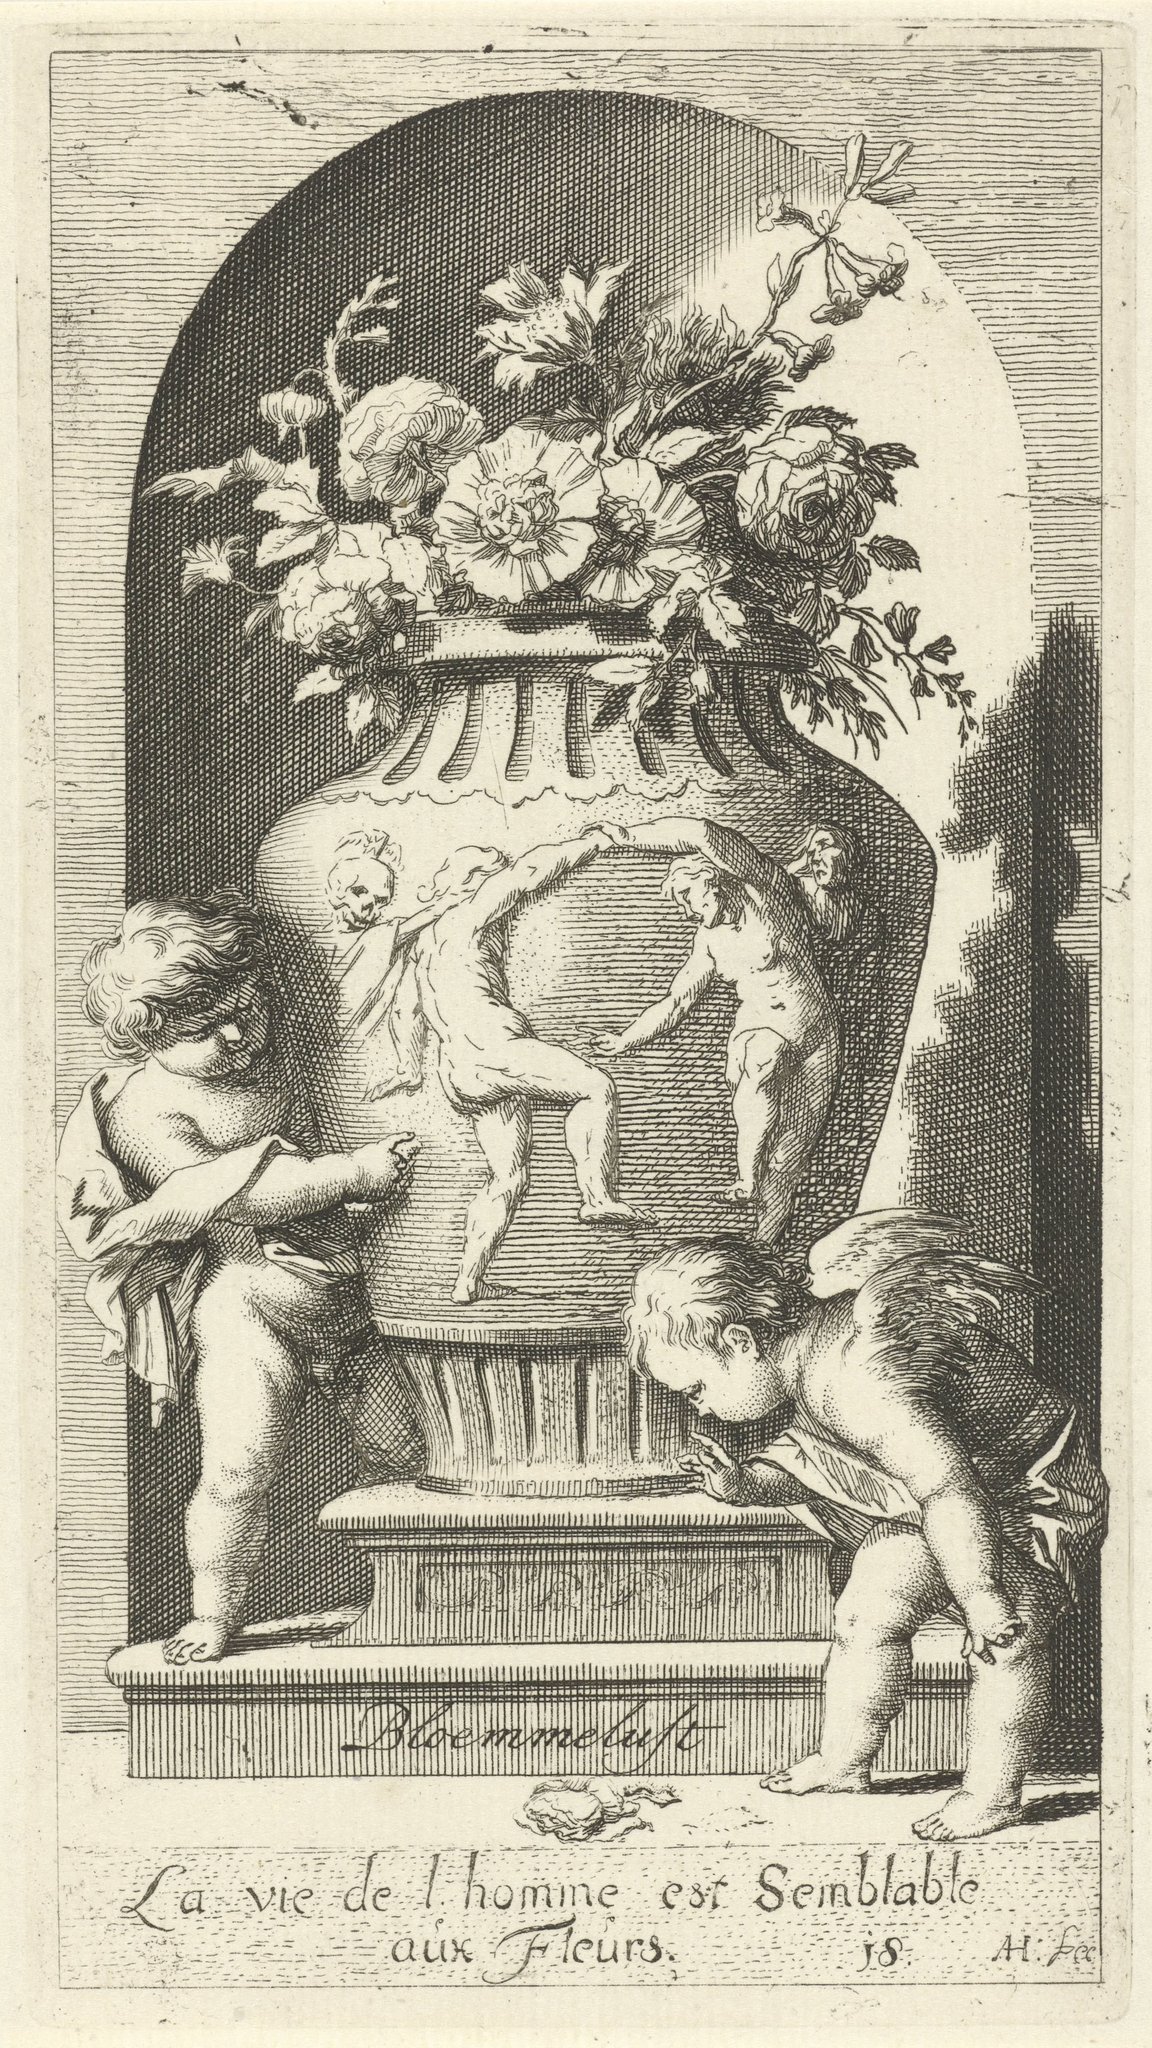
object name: print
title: Twee putti bij een vaas met bloemen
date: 1710-1719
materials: paper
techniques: engraving, etching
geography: amsterdam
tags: angel(s) represented as child(ren), garden vase, vitality and mortality (opposing concepts), flowers (+ plants used symbolically)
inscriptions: collector's mark: Lugt 2228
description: Twee putti bij een tuinvaas met bloemen in een nis. De rechter putto kijkt naar een verwelkte roos op de grond. De linker putto wijst naar de vaas, waarop de Dood de schouder vastheeft van een dansend figuur. Onderaan twee regels in het Frans, met een vergelijking van het menselijk leven met de bloei en het vergaan van bloemen. Prent uit een serie van 41 zinnebeelden.